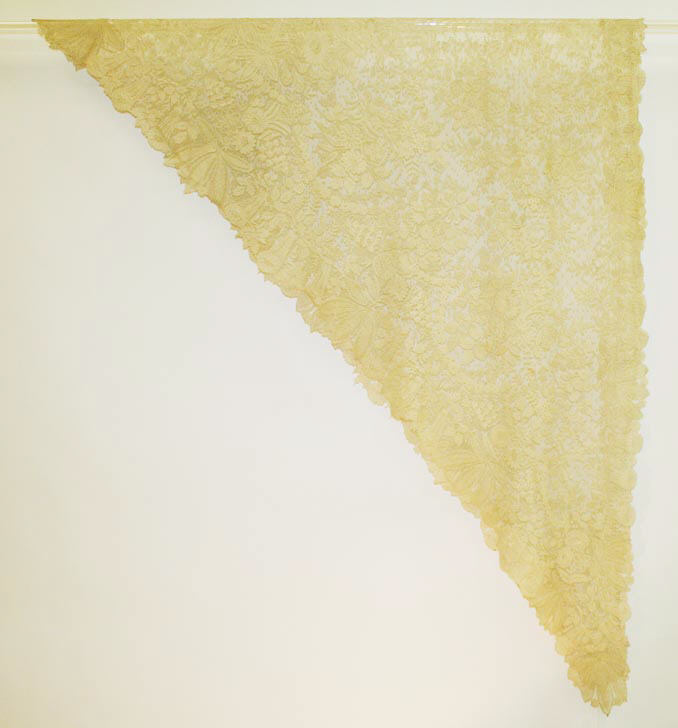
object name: shawl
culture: belgian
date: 1834-1866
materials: cotton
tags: flowers